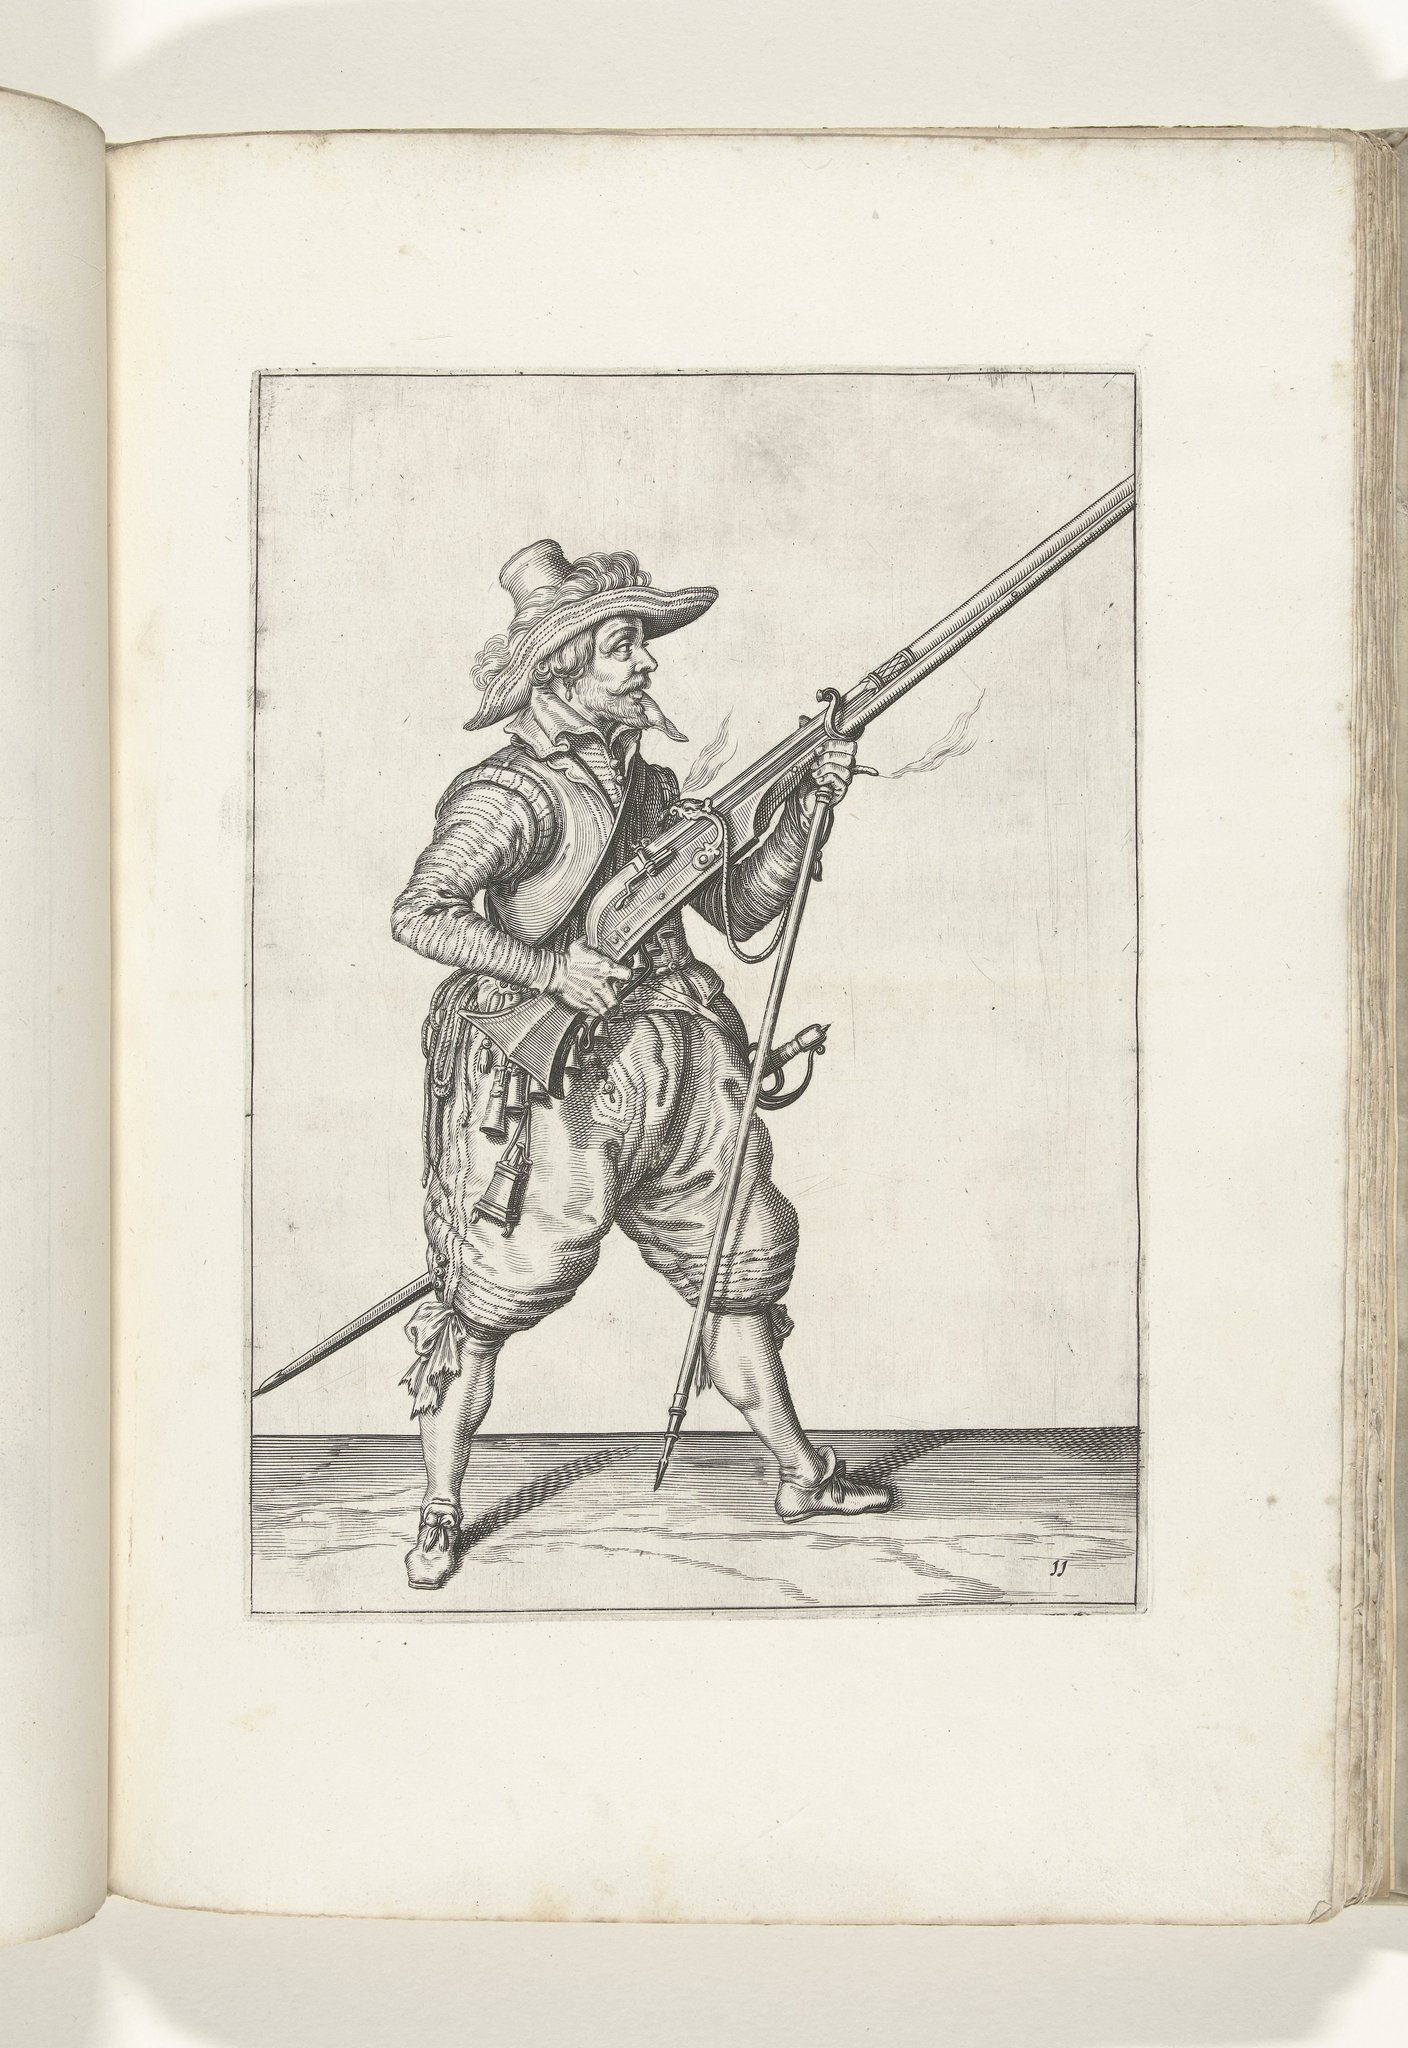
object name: print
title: Soldaat die zijn furket onder zijn musket plaatst (nr. 11), ca. 1600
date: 1597-1607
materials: paper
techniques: engraving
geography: northern netherlands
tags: maurice (prince of orange), handling of weapons ~ military training, weapons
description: Een soldaat, ten voeten uit, naar rechts, die een musket (een bepaald type vuurwapen) met de rechterhand schuin omhoog gericht vasthoudt, terwijl hij een furket (musketvork) onder de loop plaatst (nr. 11), ca. 1600. Plaat 11 in de instructies voor het hanteren van het musket: Corte onderrechtinghe op de figuerliicke afbeeldinghe, soo veel aengaet het recht ghebruyck vant Musquet. Onderdeel van de illustraties in: J. de Gheyn, Wapenhandelinghe van Roers Musquetten ende spiessen, 's-Gravenhage, 1607. Krijgswezen rond 1600.